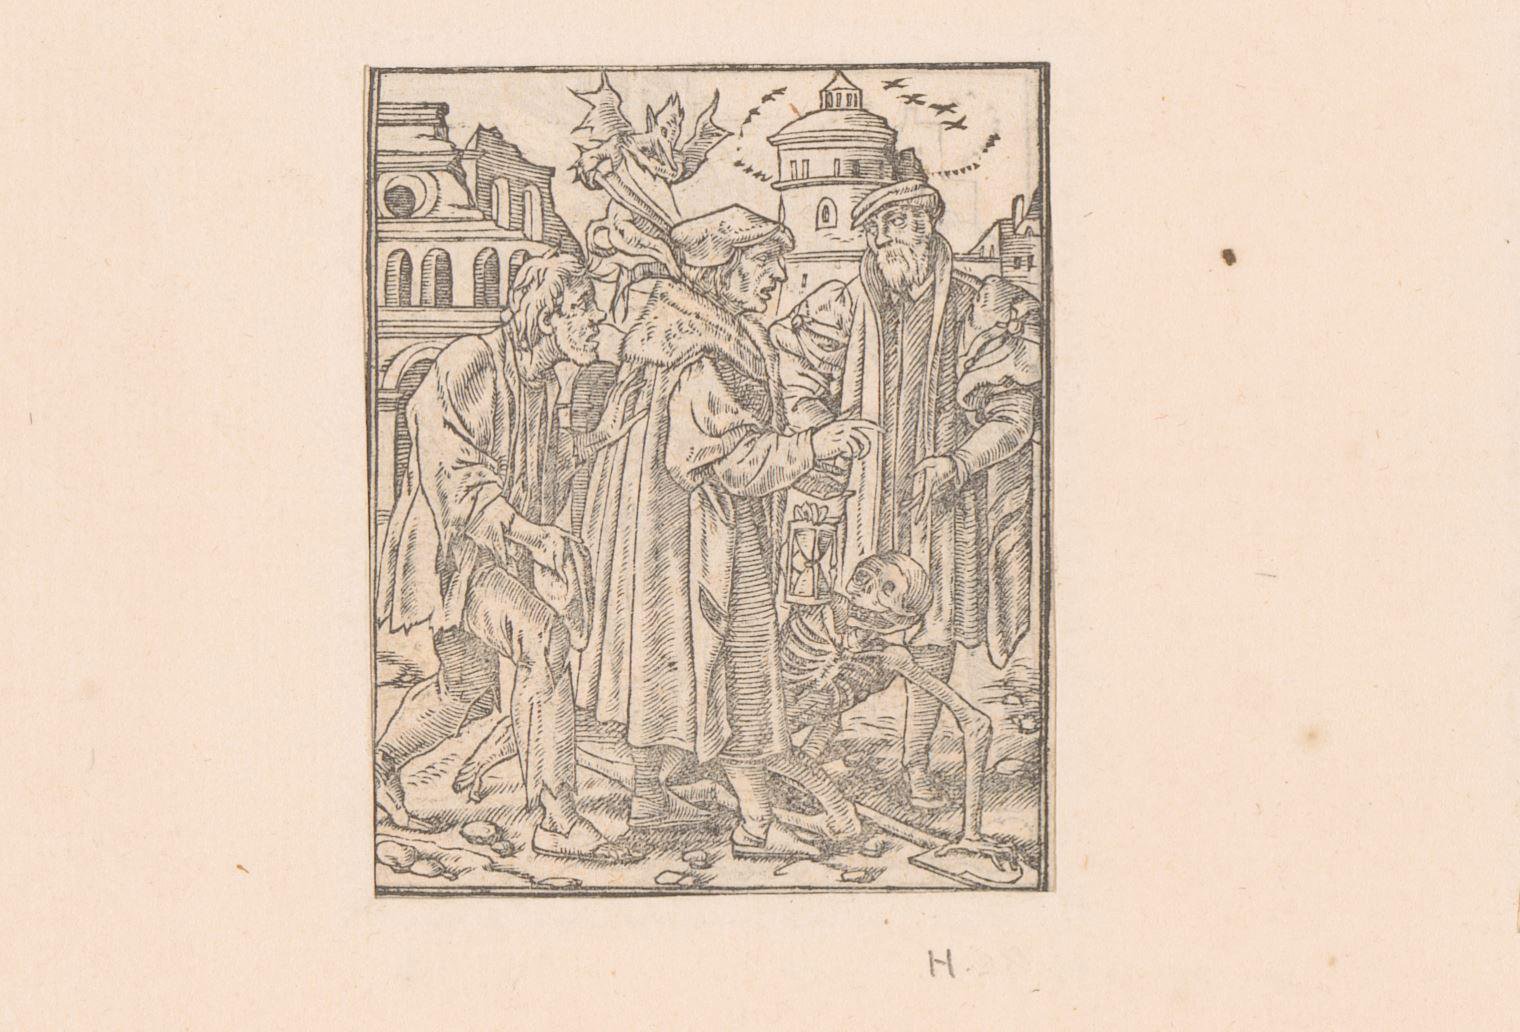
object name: book illustration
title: Kopieën naar Holbeins Dodendans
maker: Anonymous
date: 1547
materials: paper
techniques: woodcut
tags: dance of death; death together with one or more human beings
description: Kopie van een prent van Hans Holbein de jongere uit 1538, voor het eerst gepubliceerd in: Imagines mortis (...). Lyon: Johannes Frellon, 1547.